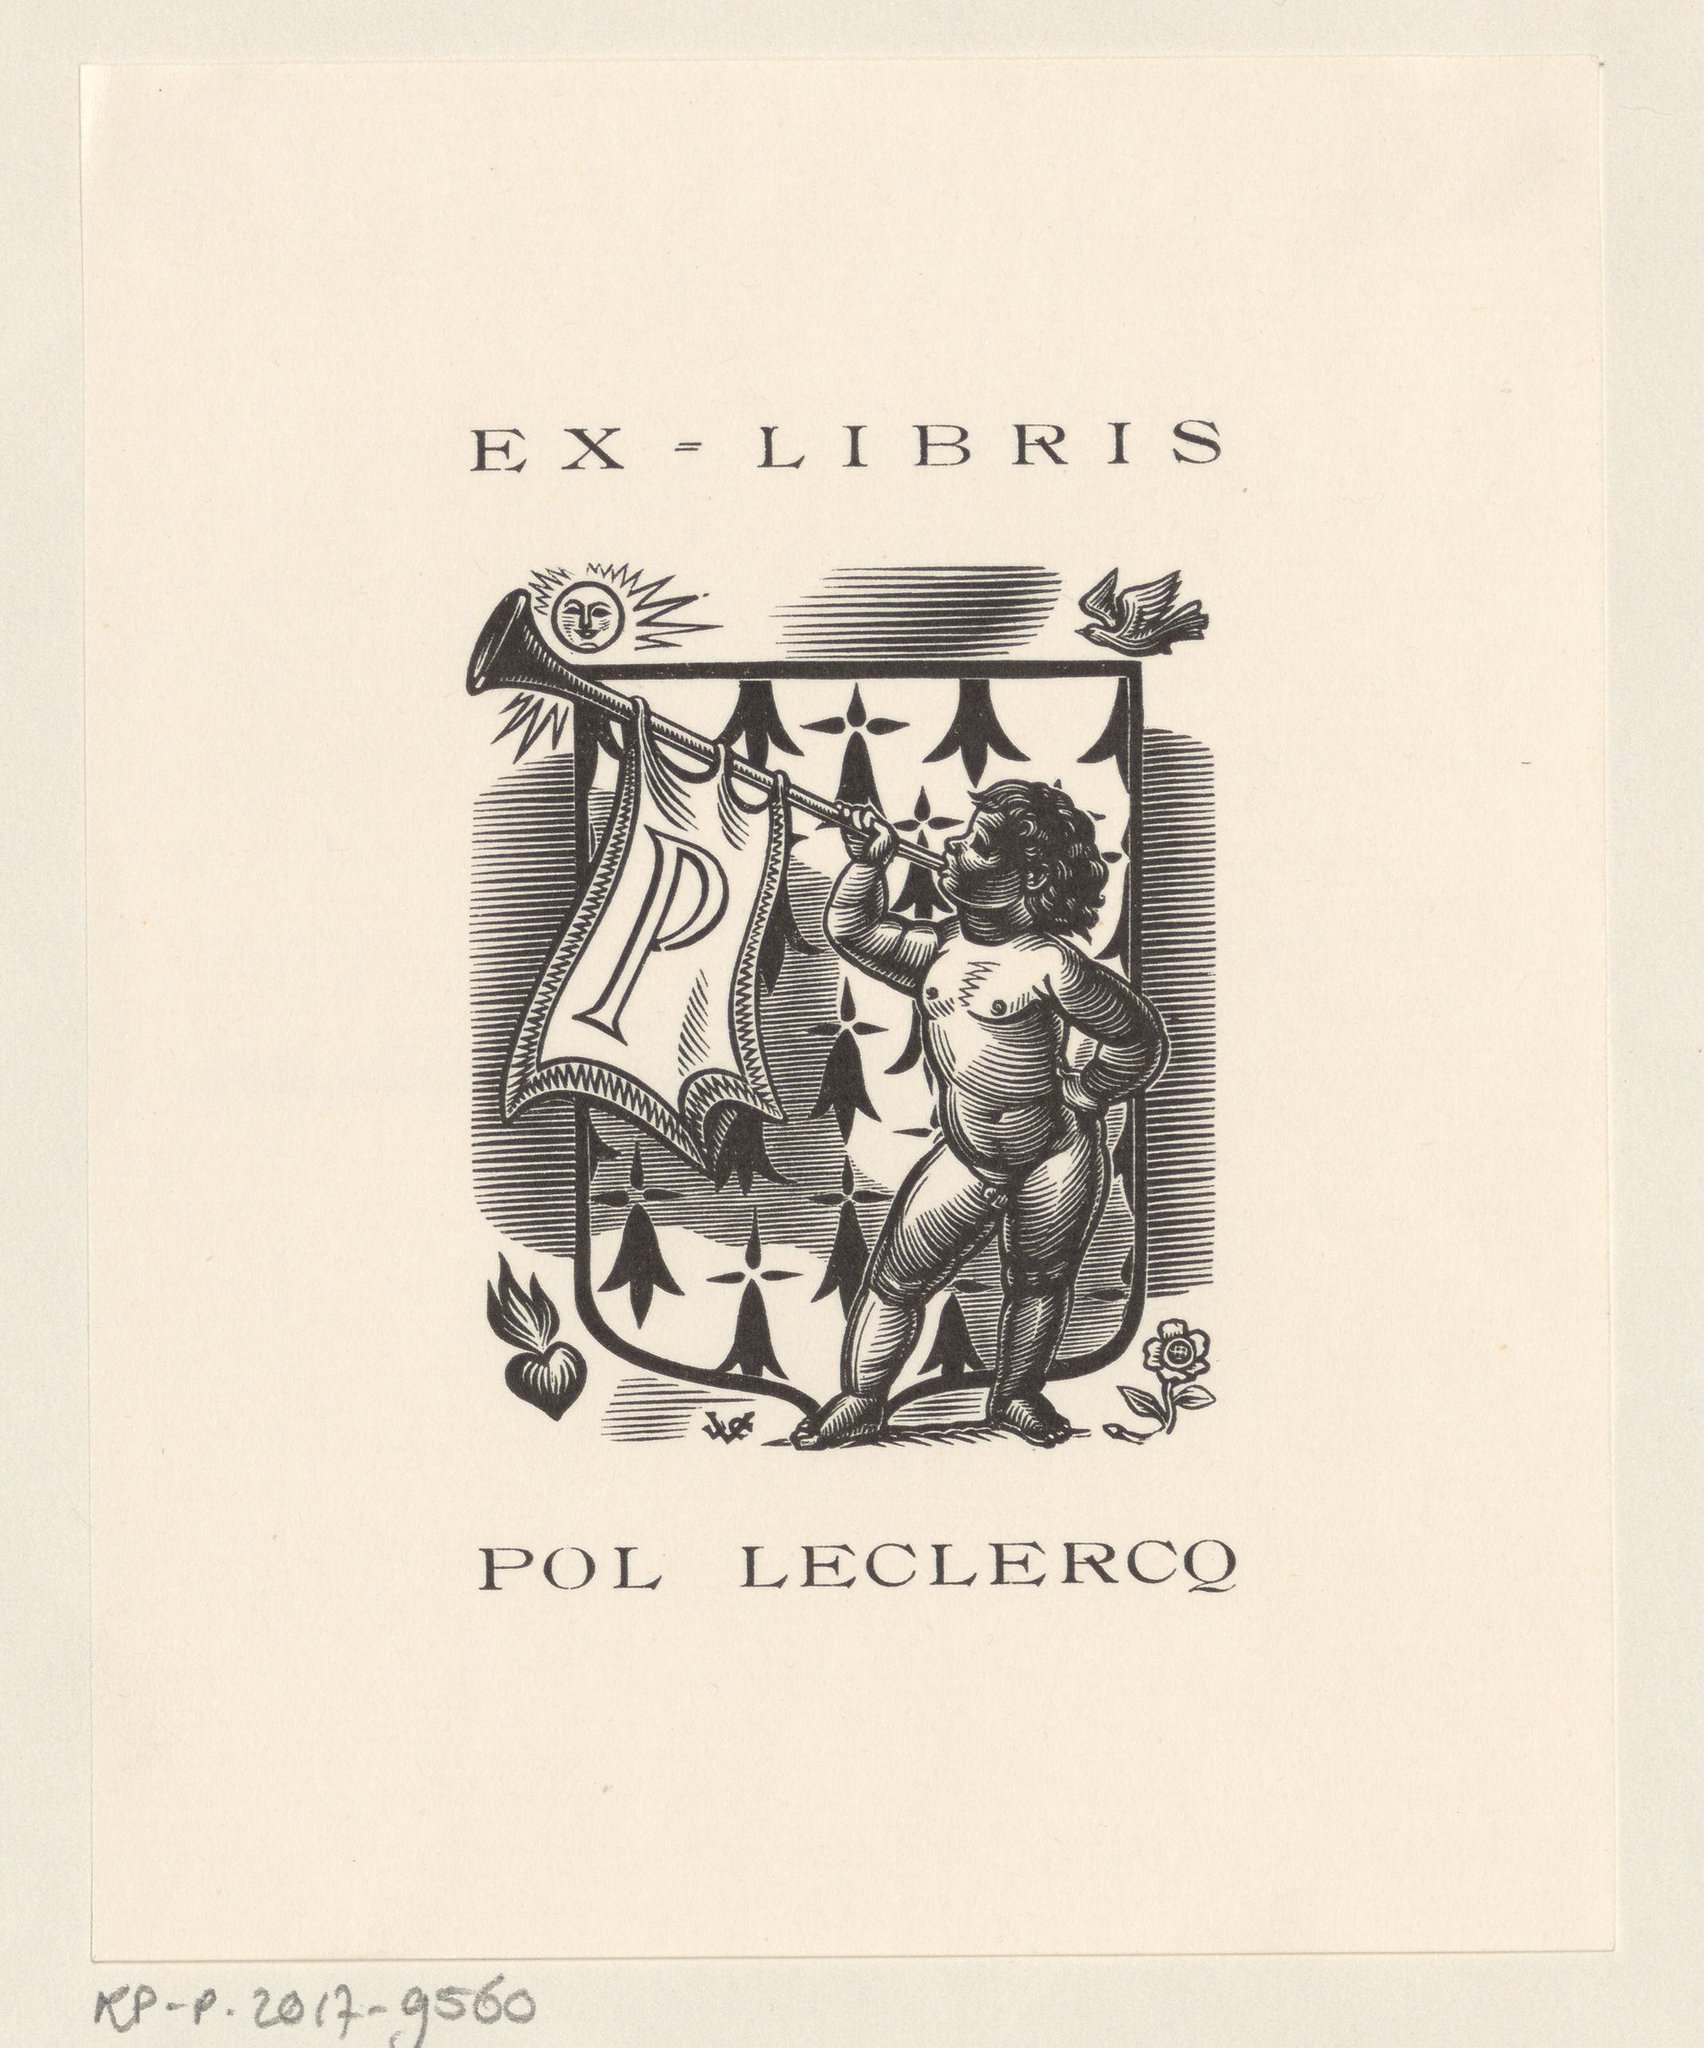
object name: bookplate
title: Ex libris van Pol Leclercq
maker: valentin le campion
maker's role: print maker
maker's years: 1861-1952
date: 1900-1952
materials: paper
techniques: printing block, engraving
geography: france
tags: heart symbolism, horn, trumpet, cornet, trombone, tuba, infant, baby, armorial bearing, heraldry